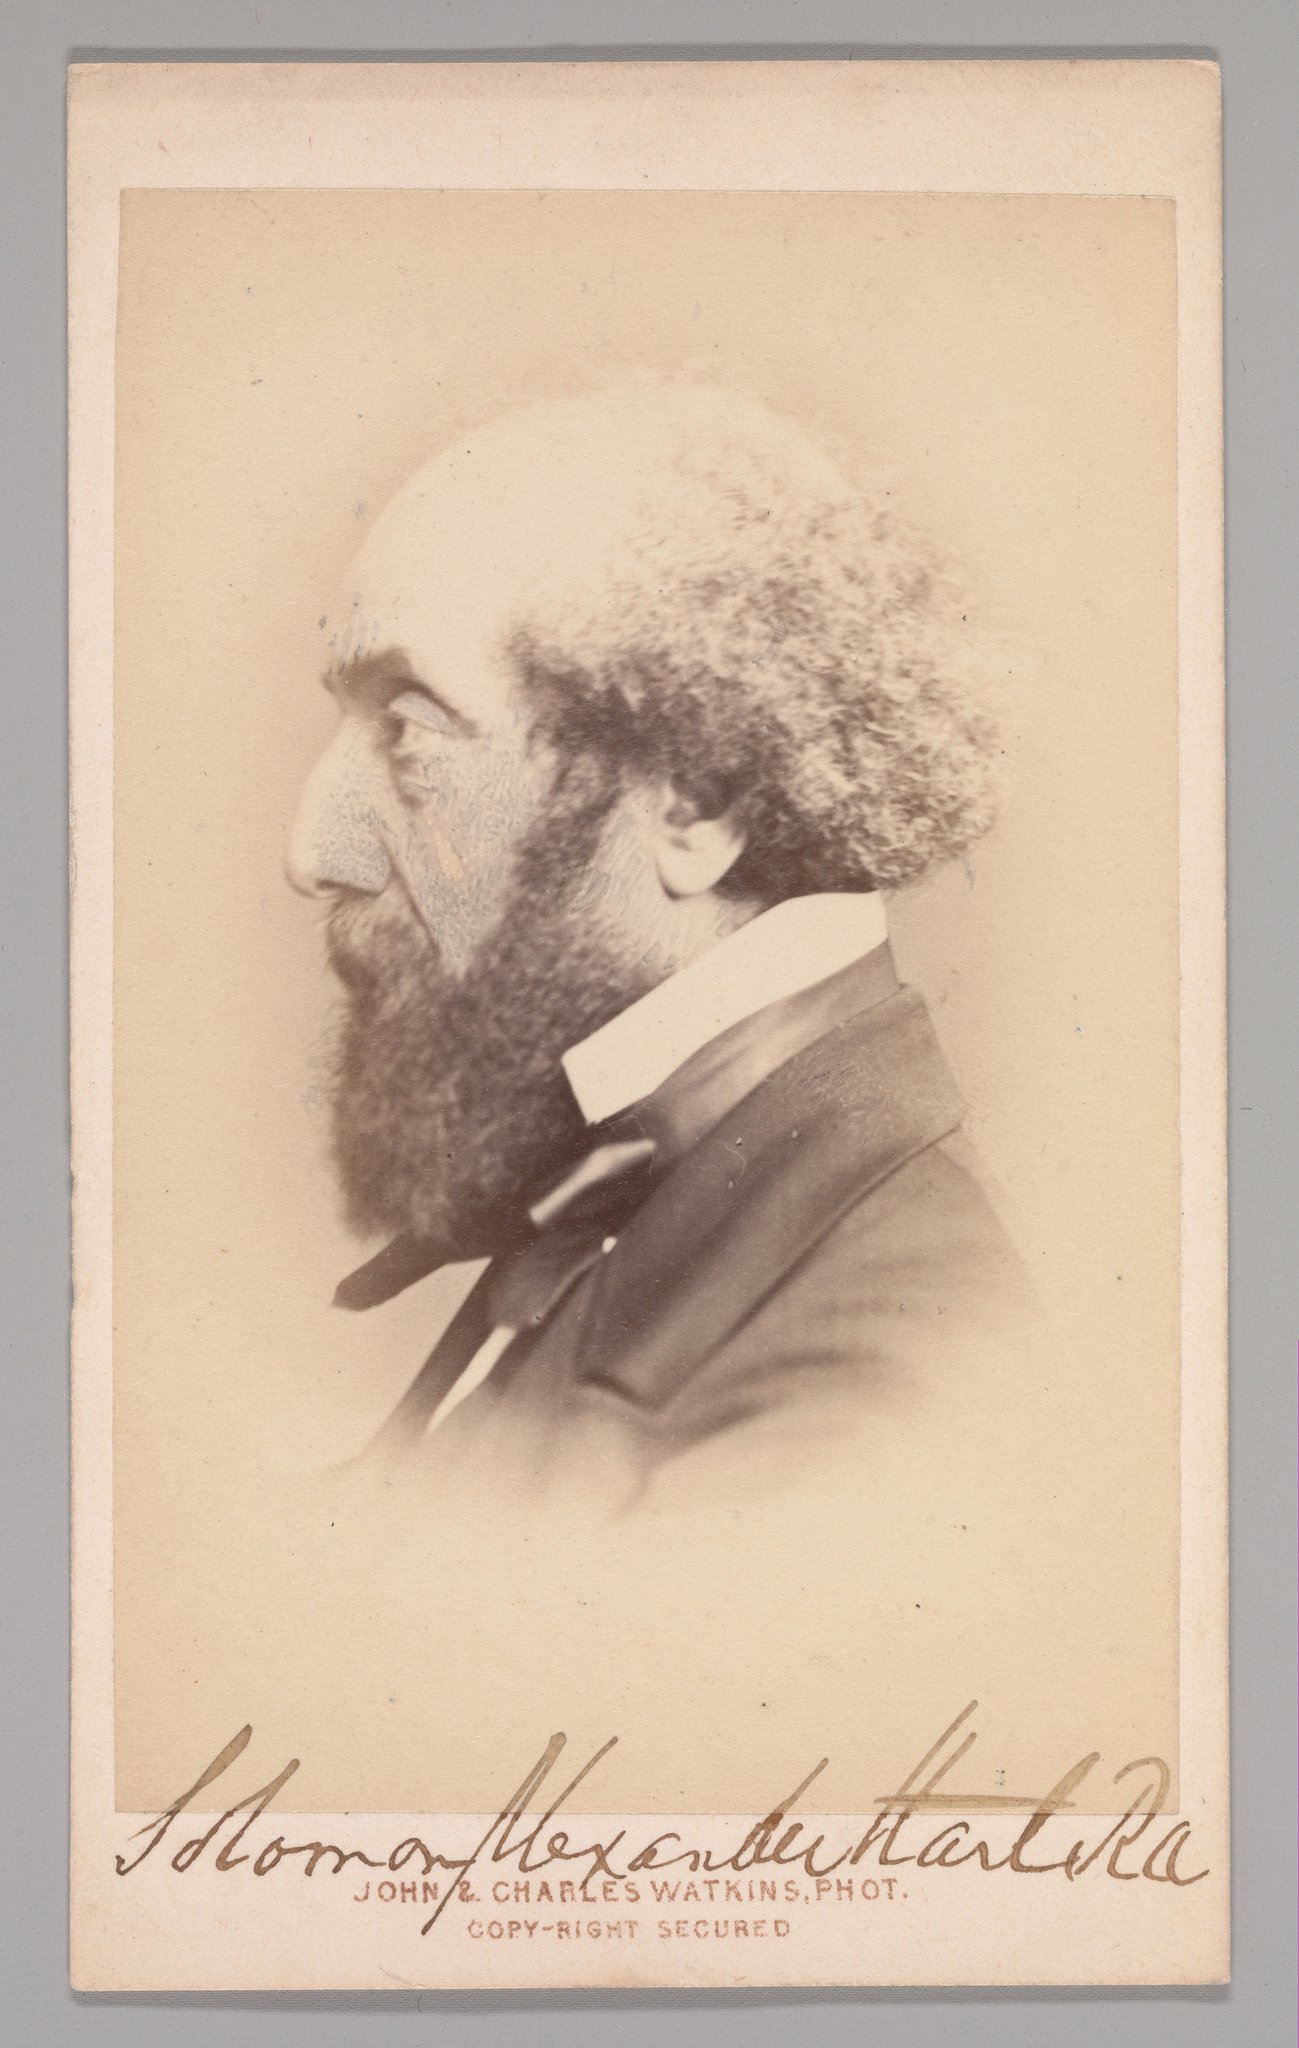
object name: carte de visite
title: [Solomon Alexander Hart]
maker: john and charles watkins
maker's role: photography studio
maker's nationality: british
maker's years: 1840-1875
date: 1860-1869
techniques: albumen silver print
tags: men,portraits,profiles